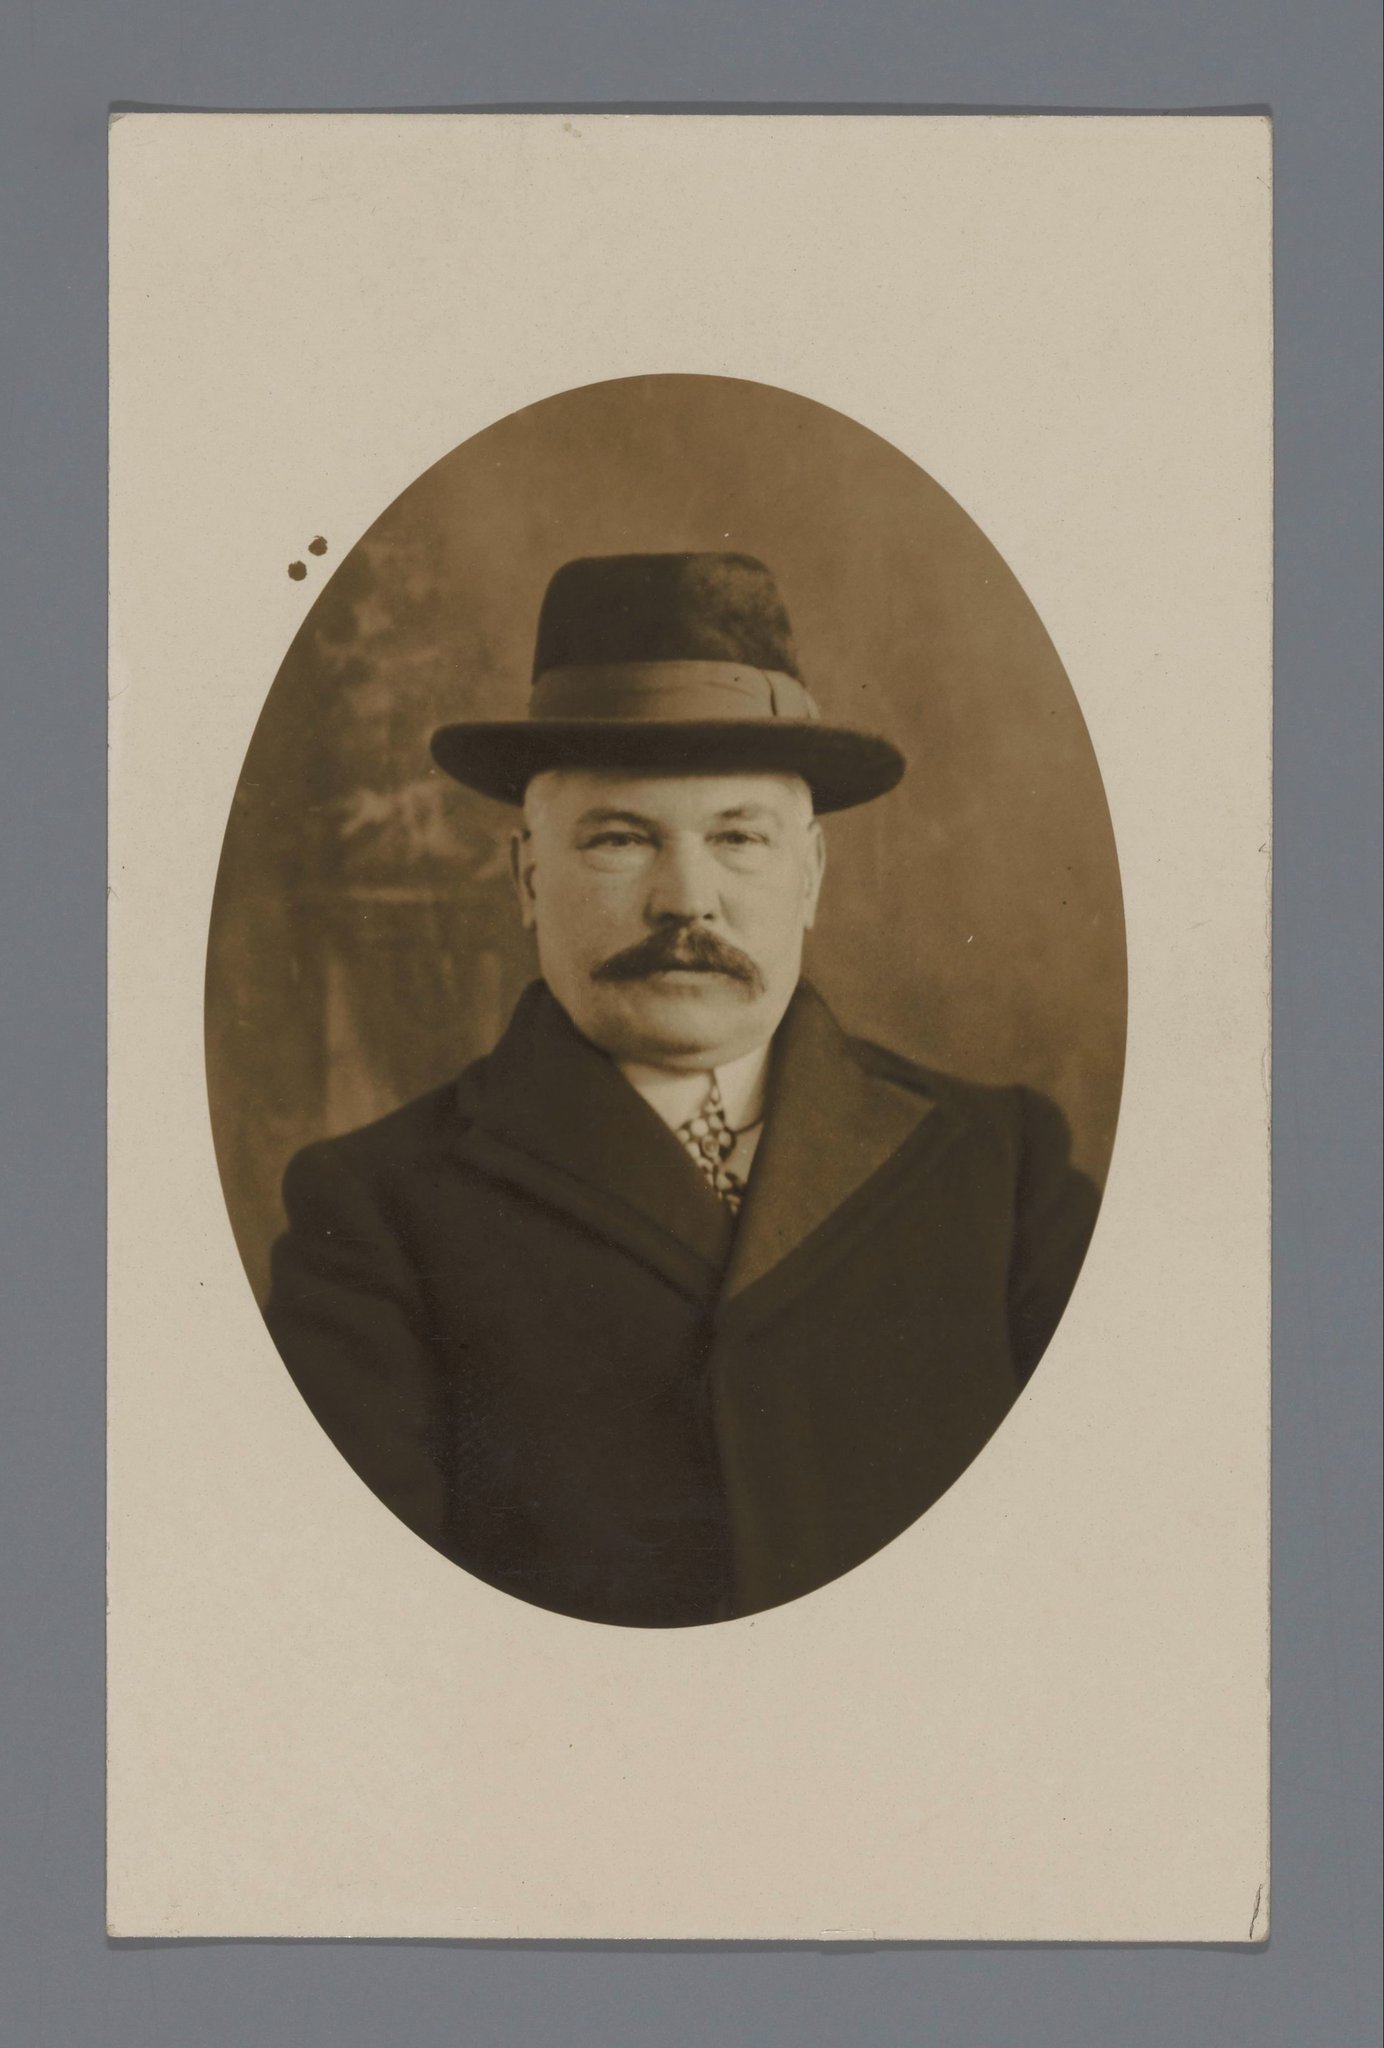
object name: photograph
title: Portret van een onbekende man met een snor en een hoed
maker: Anonymous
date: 1907-1915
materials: photographic support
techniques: gelatin silver print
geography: great britain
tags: studio ~ photographer, adult man, head-gear: hat